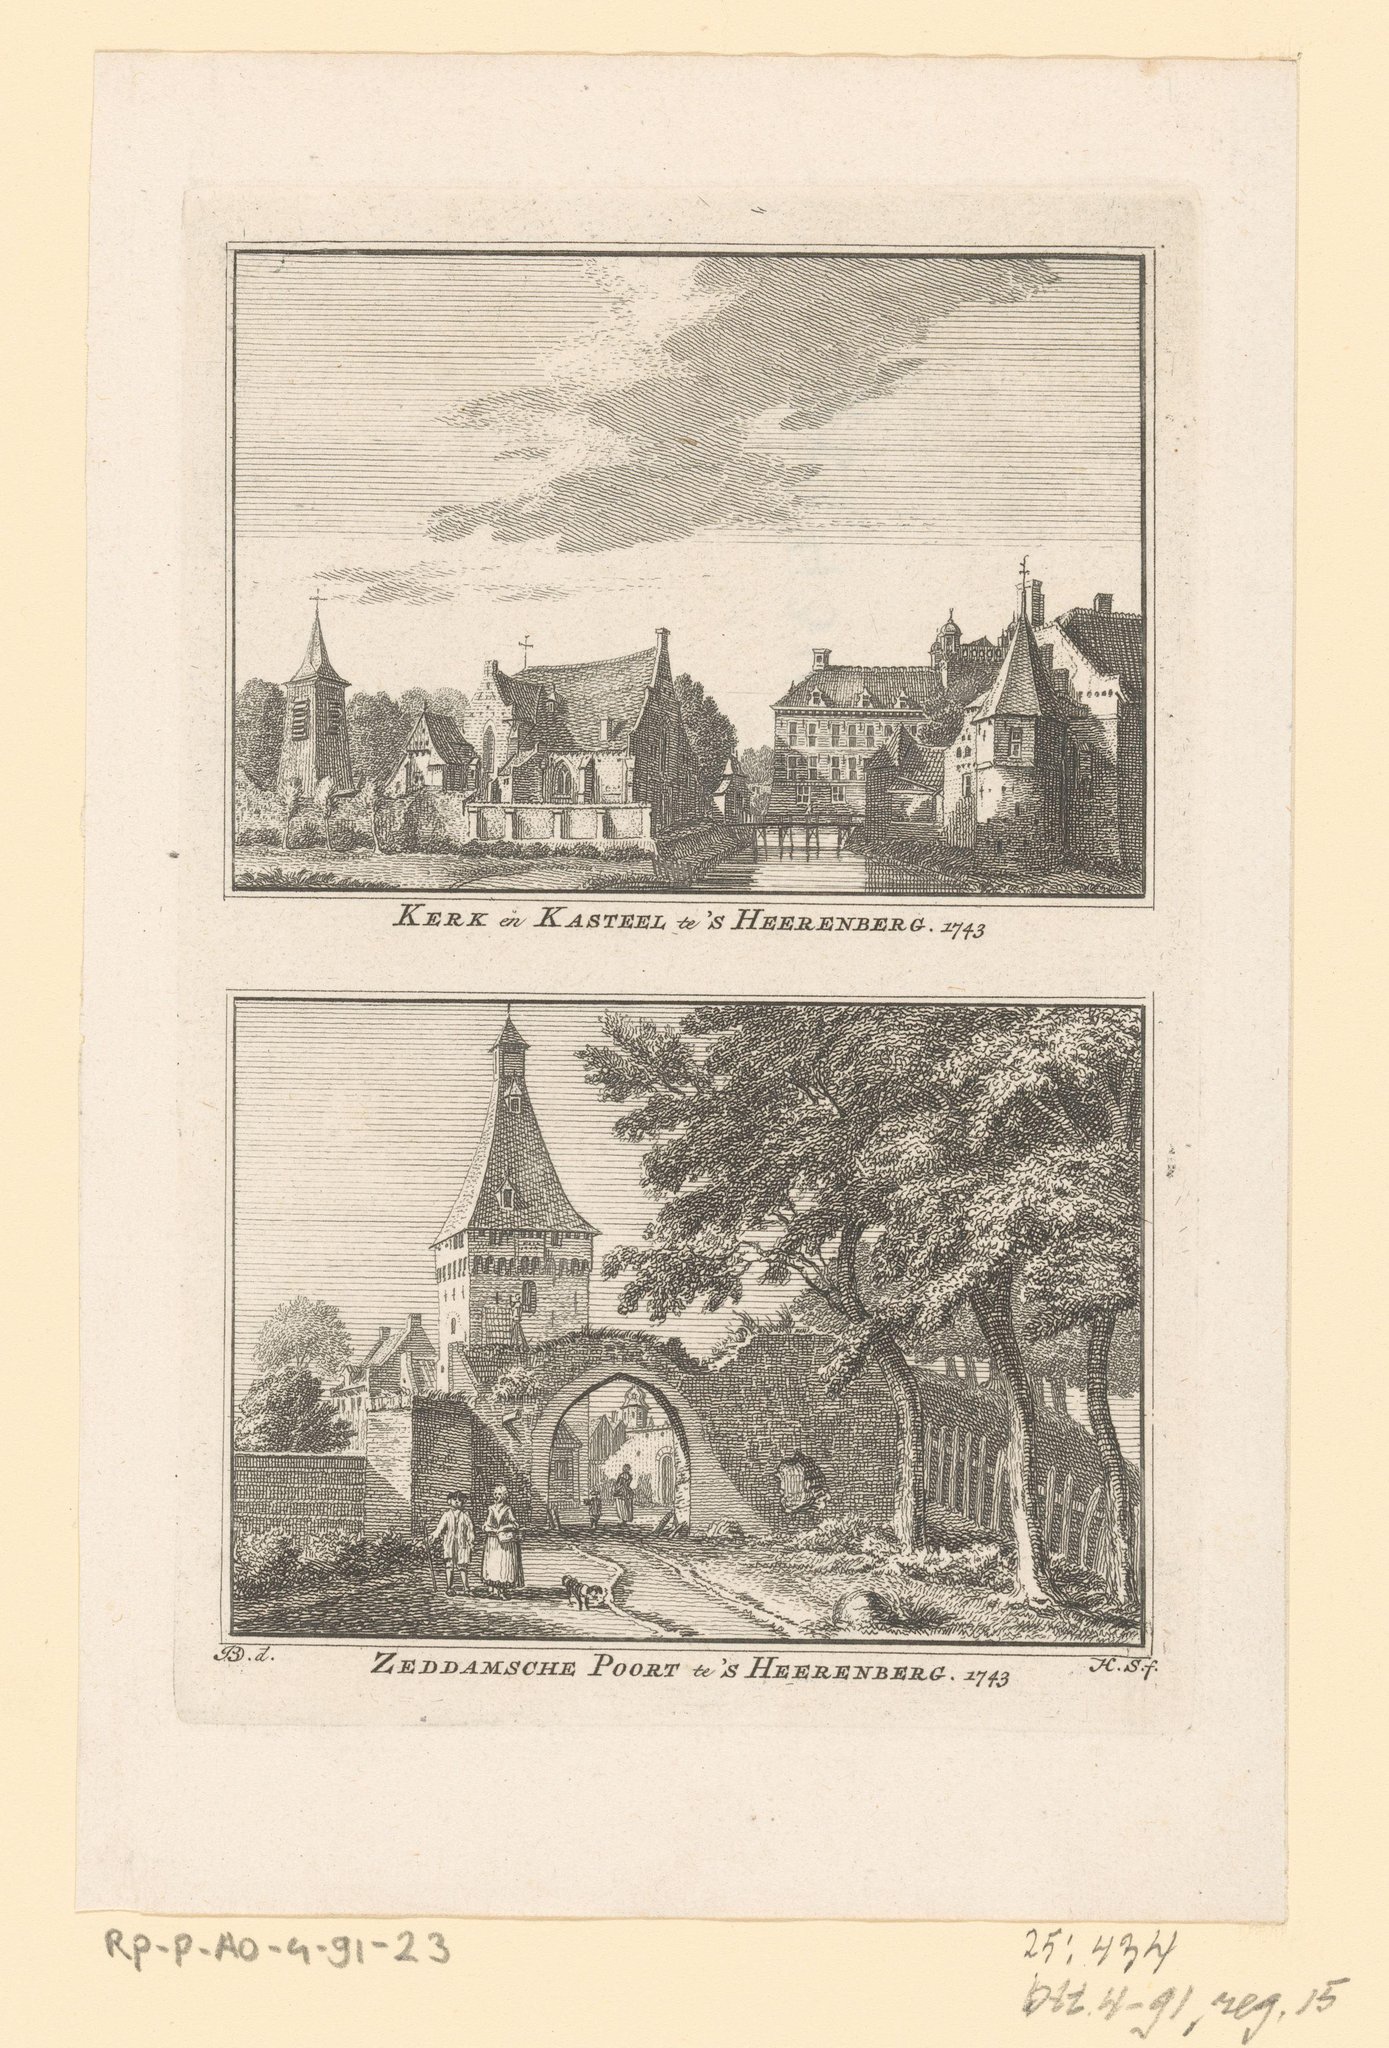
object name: print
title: Kerk en Kasteel te 's Heerenberg. 1743 / Zeddamsche Poort te 's Heerenberg. 1743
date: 1745-1792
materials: paper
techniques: etching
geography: haarlem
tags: prospect of village, silhouette of village, castle, church (exterior)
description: Prent ook gebruikt in: Het verheerlykt Nederland of kabinet van hedendaagsche gezigten van steden, dorpen (…). 9 delen. Amsterdam: Isaak Tirion en weduwe Isaak Tirion, 1745-1774, dl. 1 (1745), ill. 65-66. Of in: Nederlandsche tafereelen; of eene keurige verzameling van negen honderd fraaije gezigten van steden, dorpen, sloten, oudheden (….). 9 delen. Amsterdam: Jan de Groot, 1792, dl. 1, ill. 65-66.